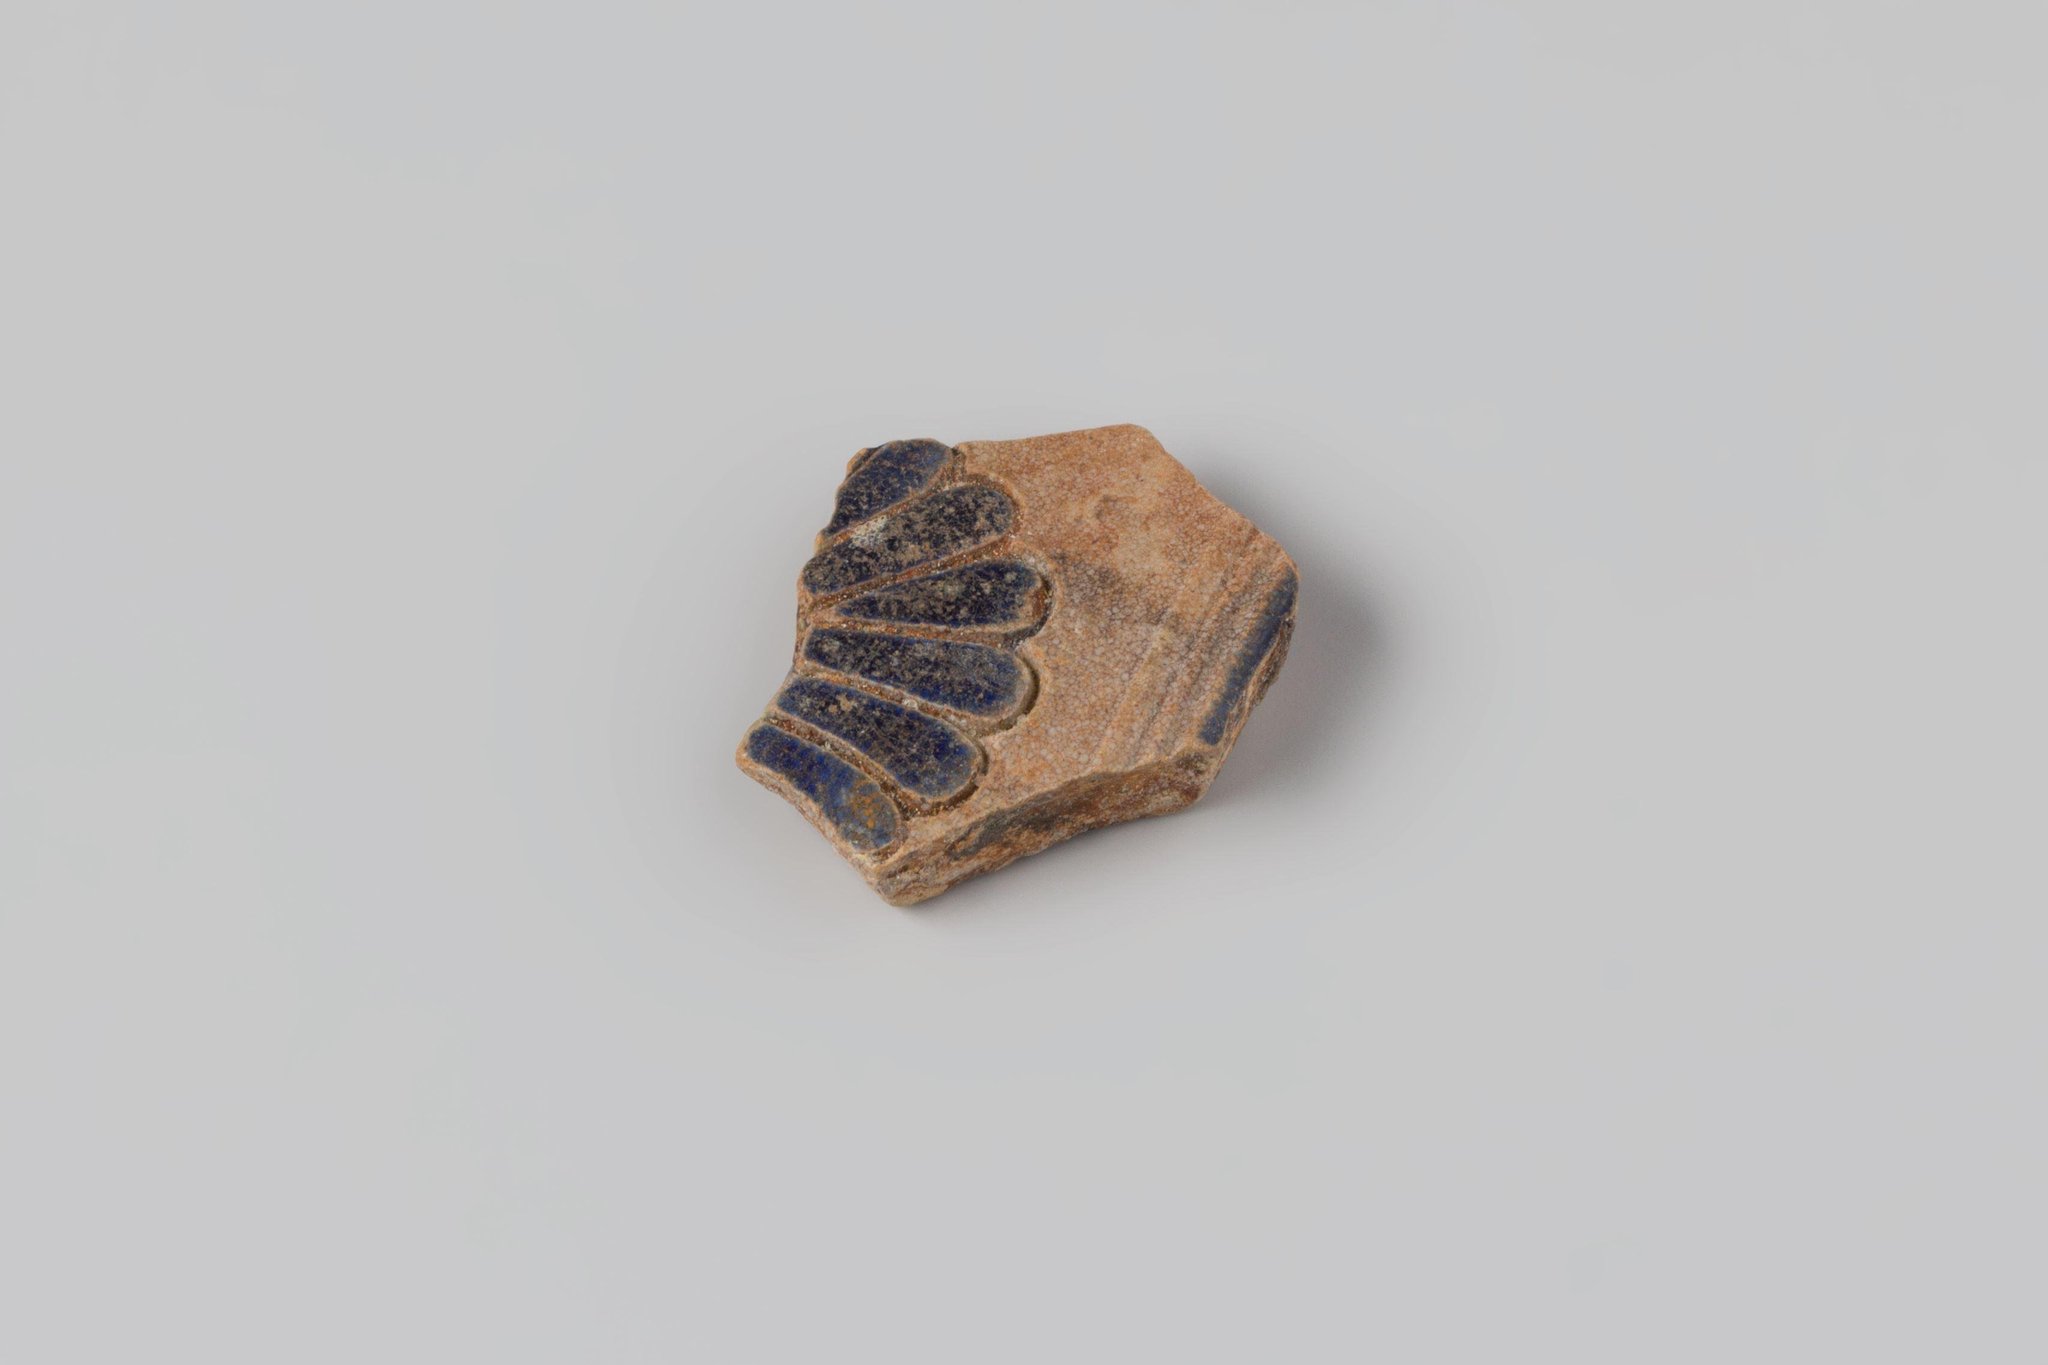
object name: sherd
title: Scherf van een pot uit het wrak van de Oost-Indiëvaarder Hollandia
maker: Anonymous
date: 1700-1743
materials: stoneware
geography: westerwald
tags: verenigde oostindische compagnie, hollandia (schip), annet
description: Stoneware, Rhenish, Westerwald, pot; of body, sim. NG 1980-27H2624r.